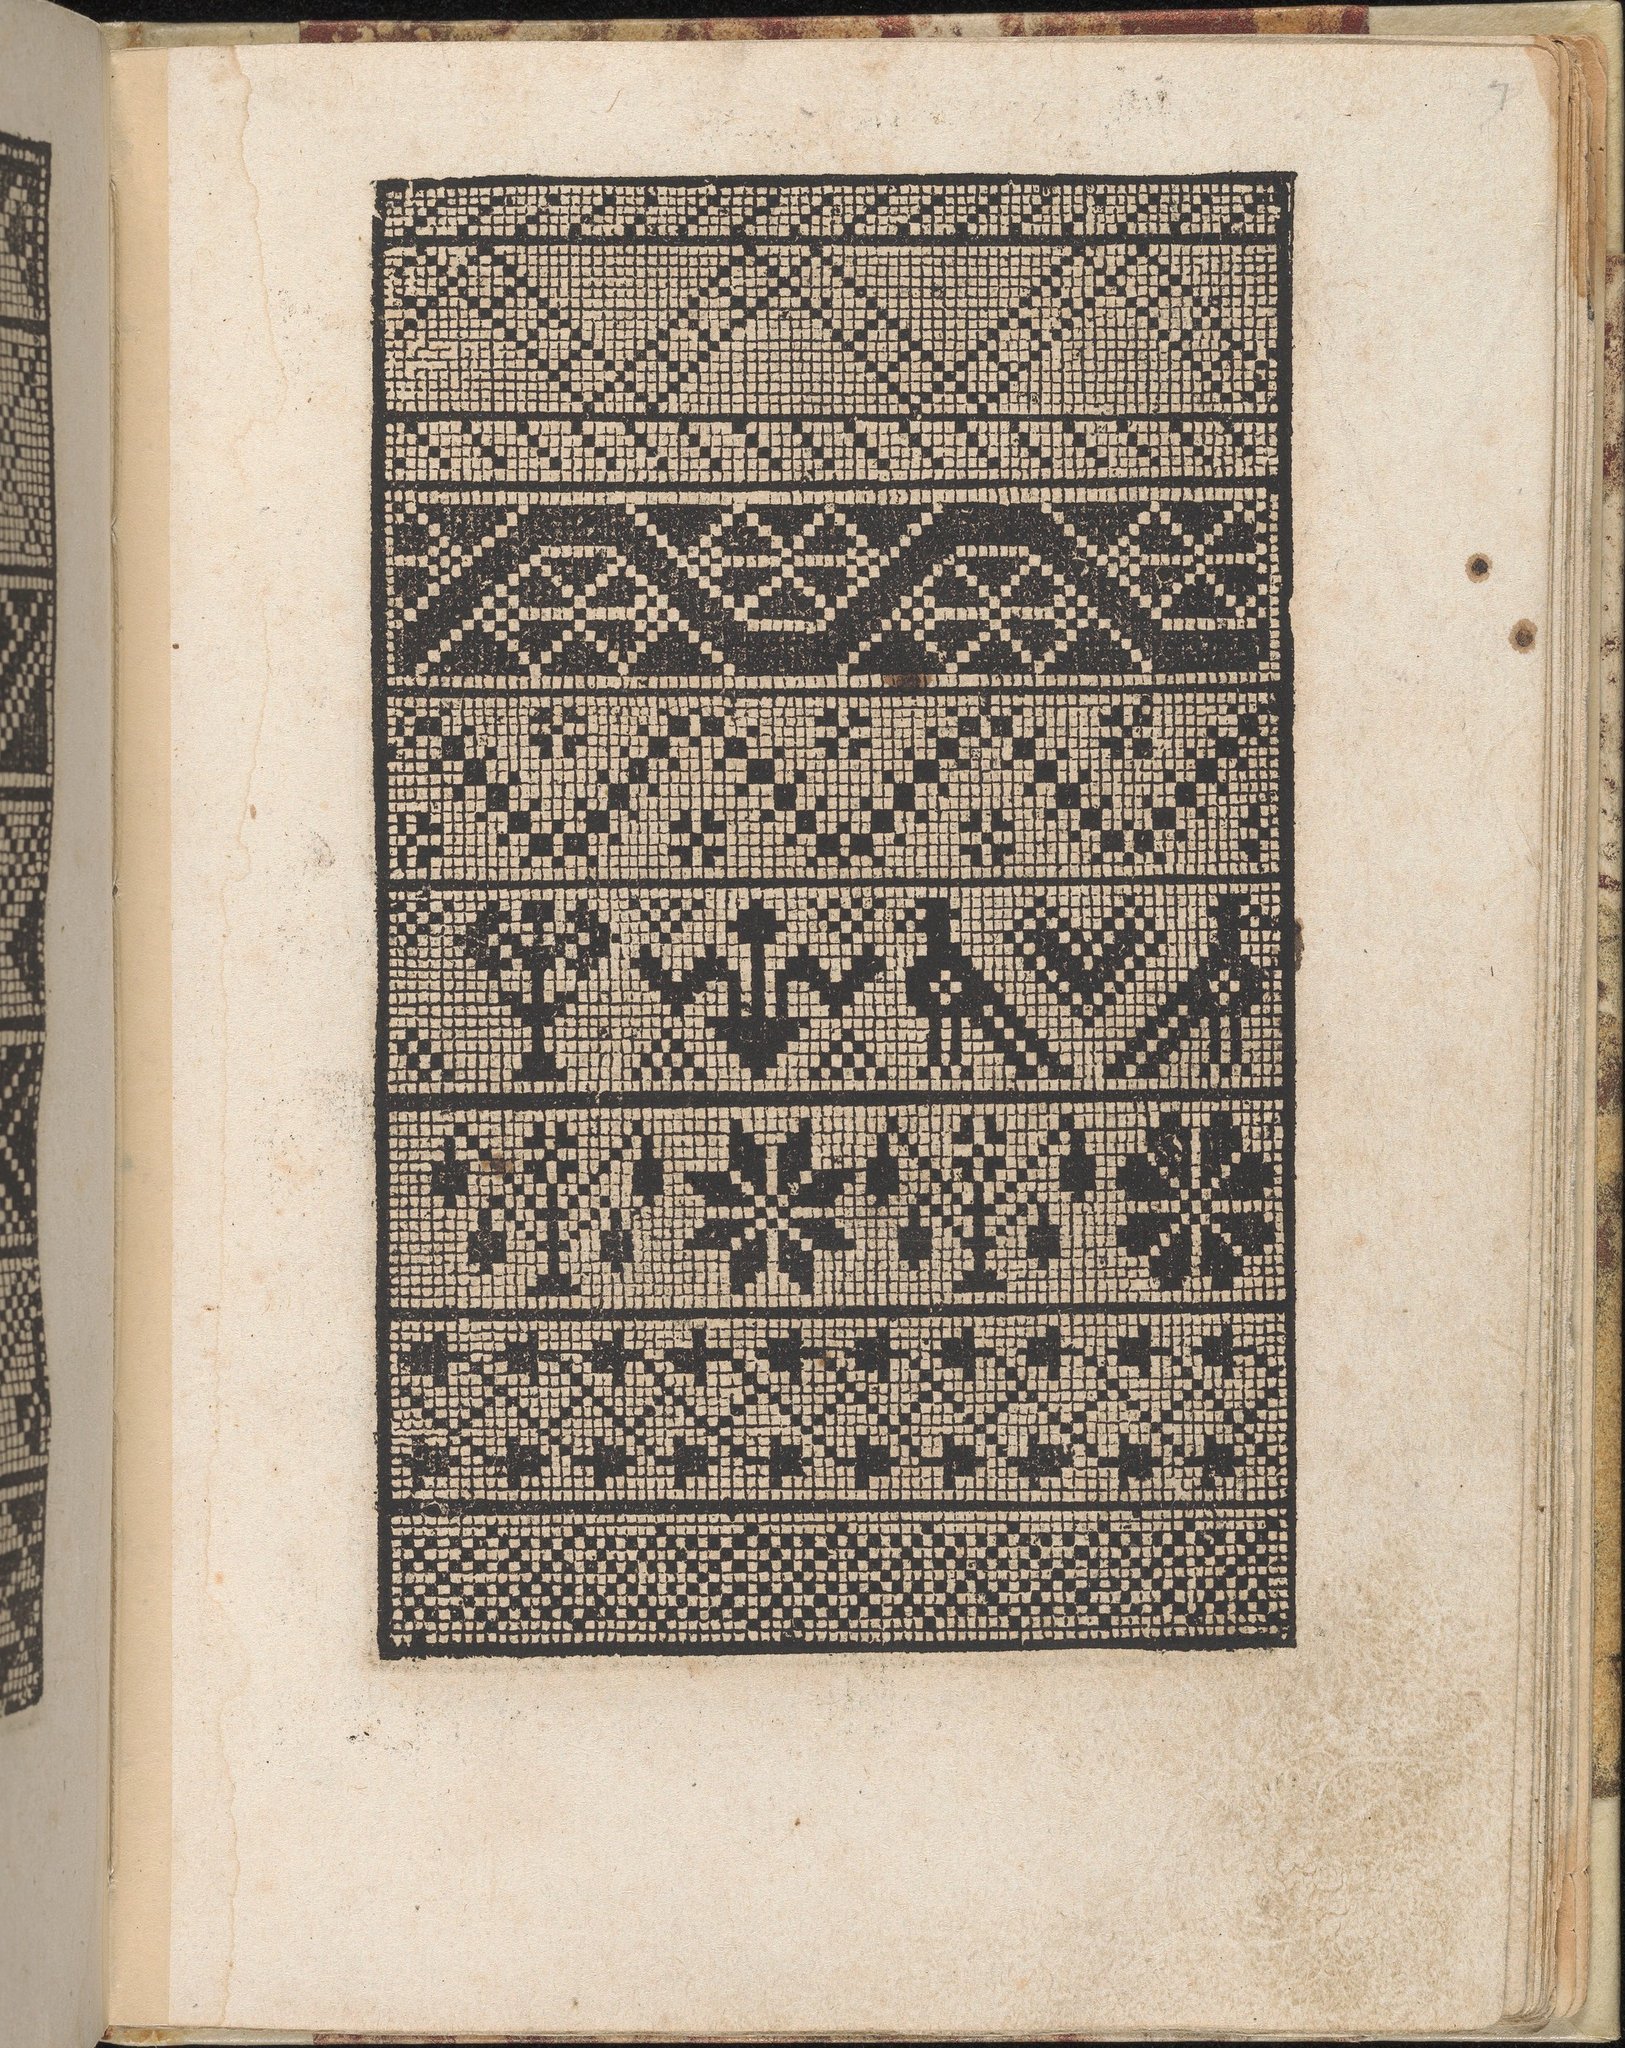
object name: book print ornament architecture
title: Ein new getruckt model Büchli...Page 7, recto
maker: johann schönsperger the younger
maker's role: publisher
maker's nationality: german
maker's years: 1490-1550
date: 1529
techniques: woodcut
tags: birds